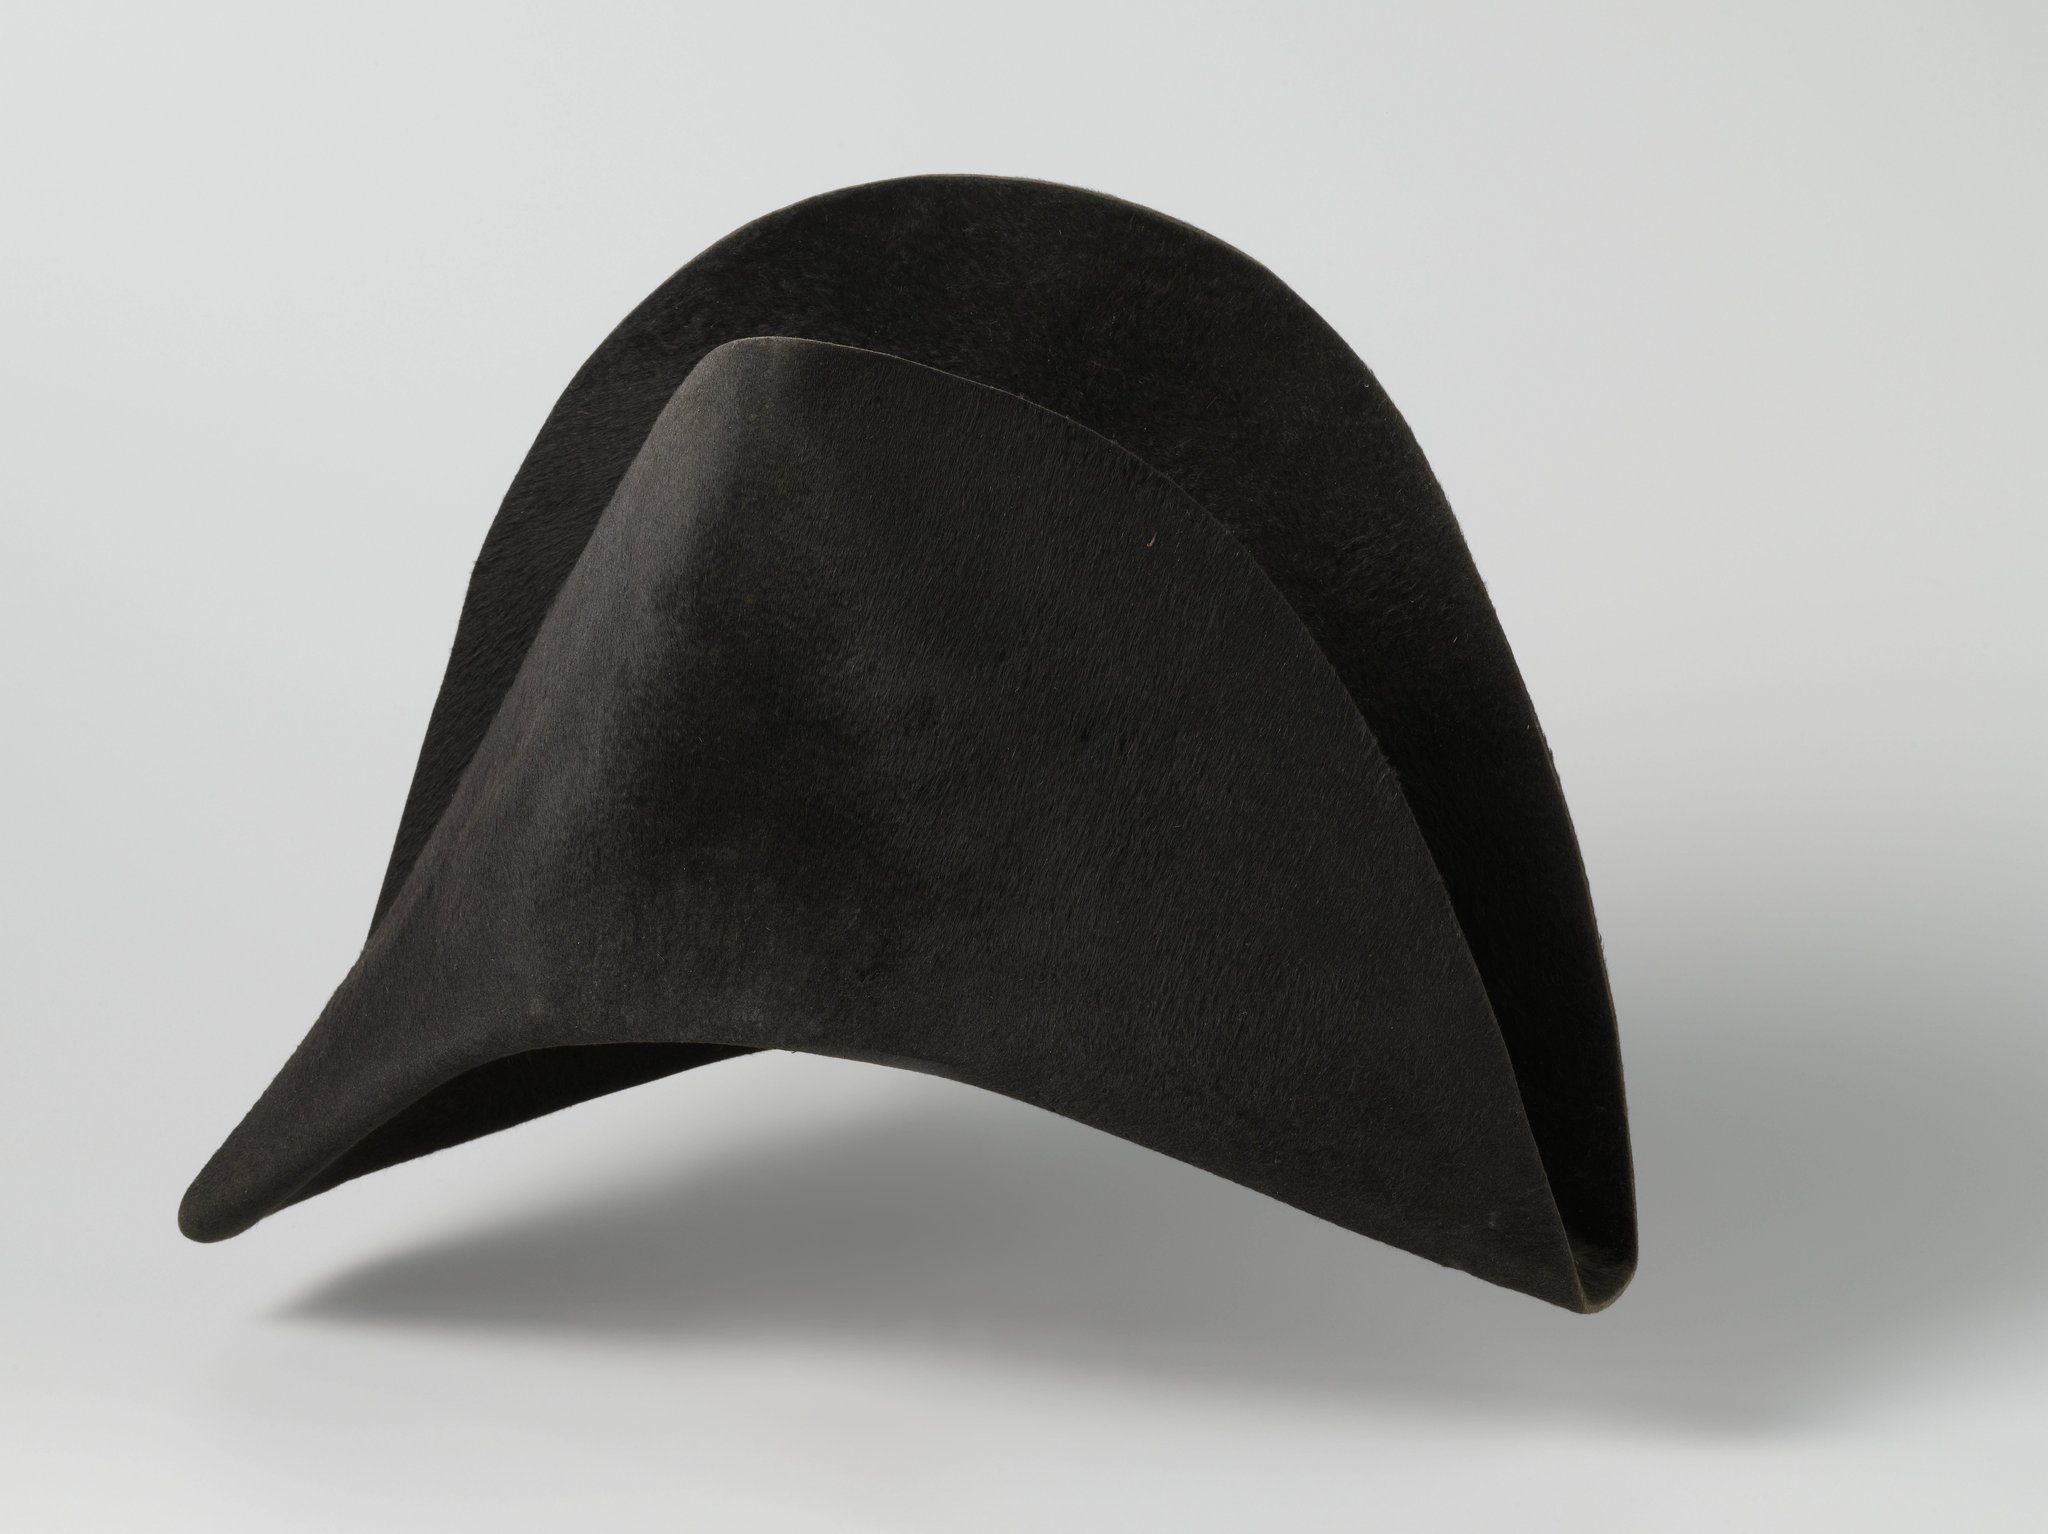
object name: hoofddeksel, hoofdbedekking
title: Two-cornered hat (bicorne)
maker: Anonymous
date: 1789-1810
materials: silk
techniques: lacquer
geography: netherlands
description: After the French Revolution (1789), the three-cornered hat (tricorne) – the symbol of the previous government known as the Ancien Régime – fell out of favour. However, a large two-cornered model, the bicorne, remained fashionable until around 1810. It was also called a corsair after its most famous wearer, Napoleon Bonaparte, who came from Corsica. This hat is made of beaver fur felt, which was expensive and very popular.